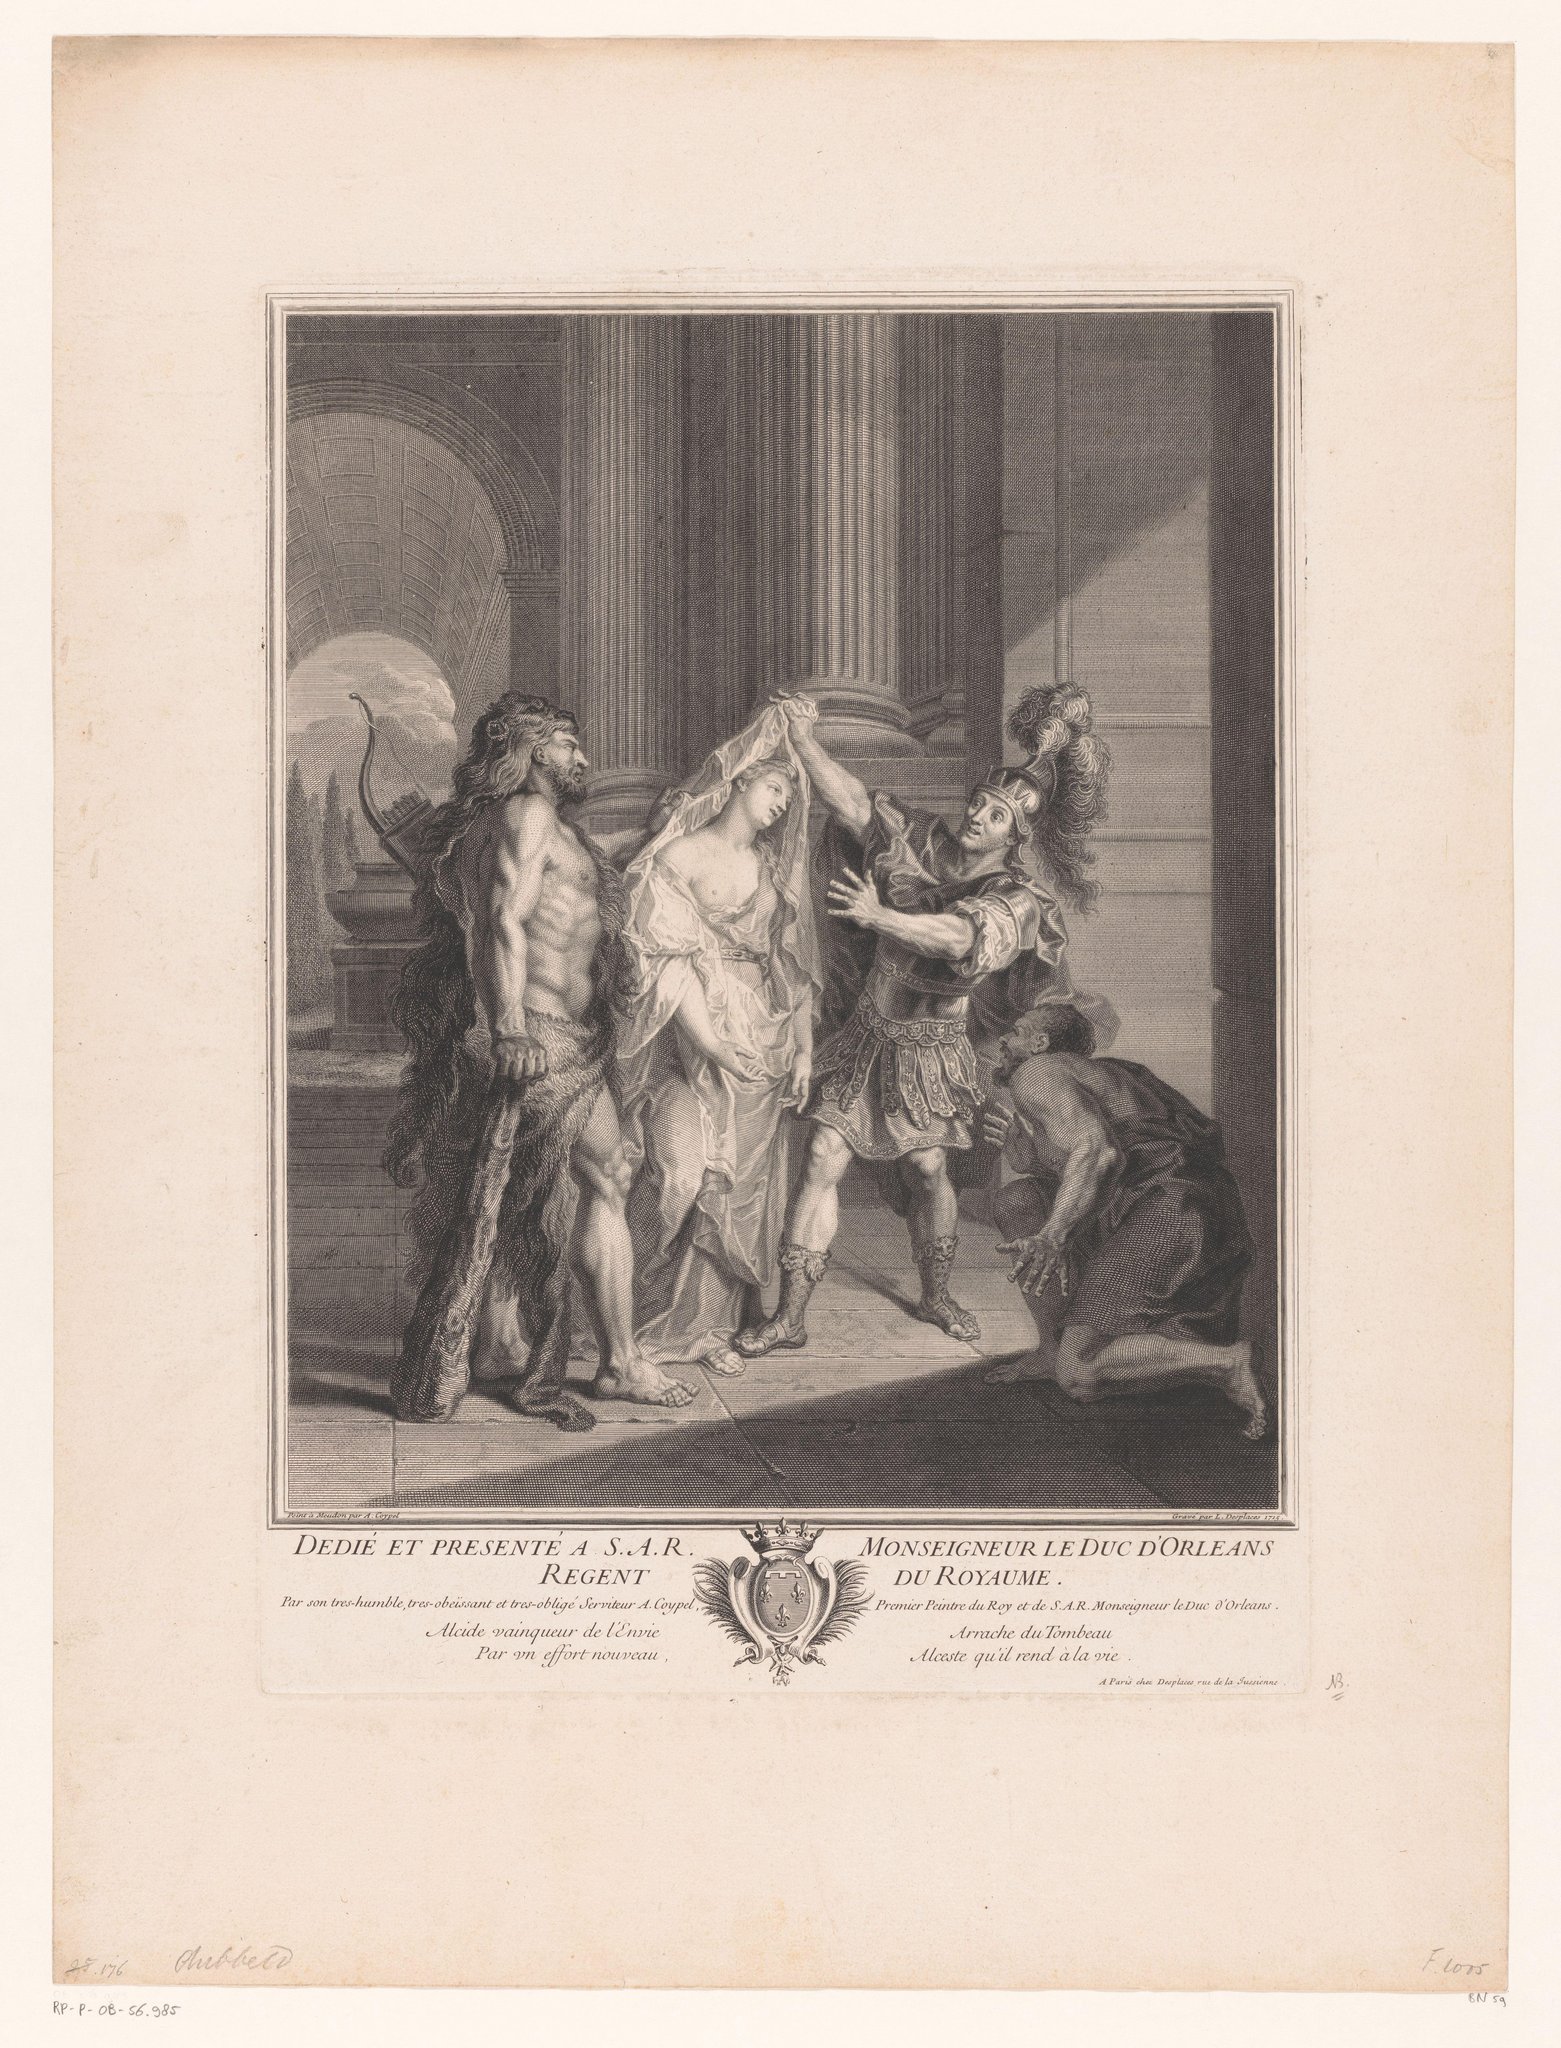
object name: print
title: Hercules brengt Alcestis terug uit de onderwereld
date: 1715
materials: paper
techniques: engraving, etching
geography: paris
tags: hercules leads alcestis out of the underworld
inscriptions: collector's mark: Lugt 240